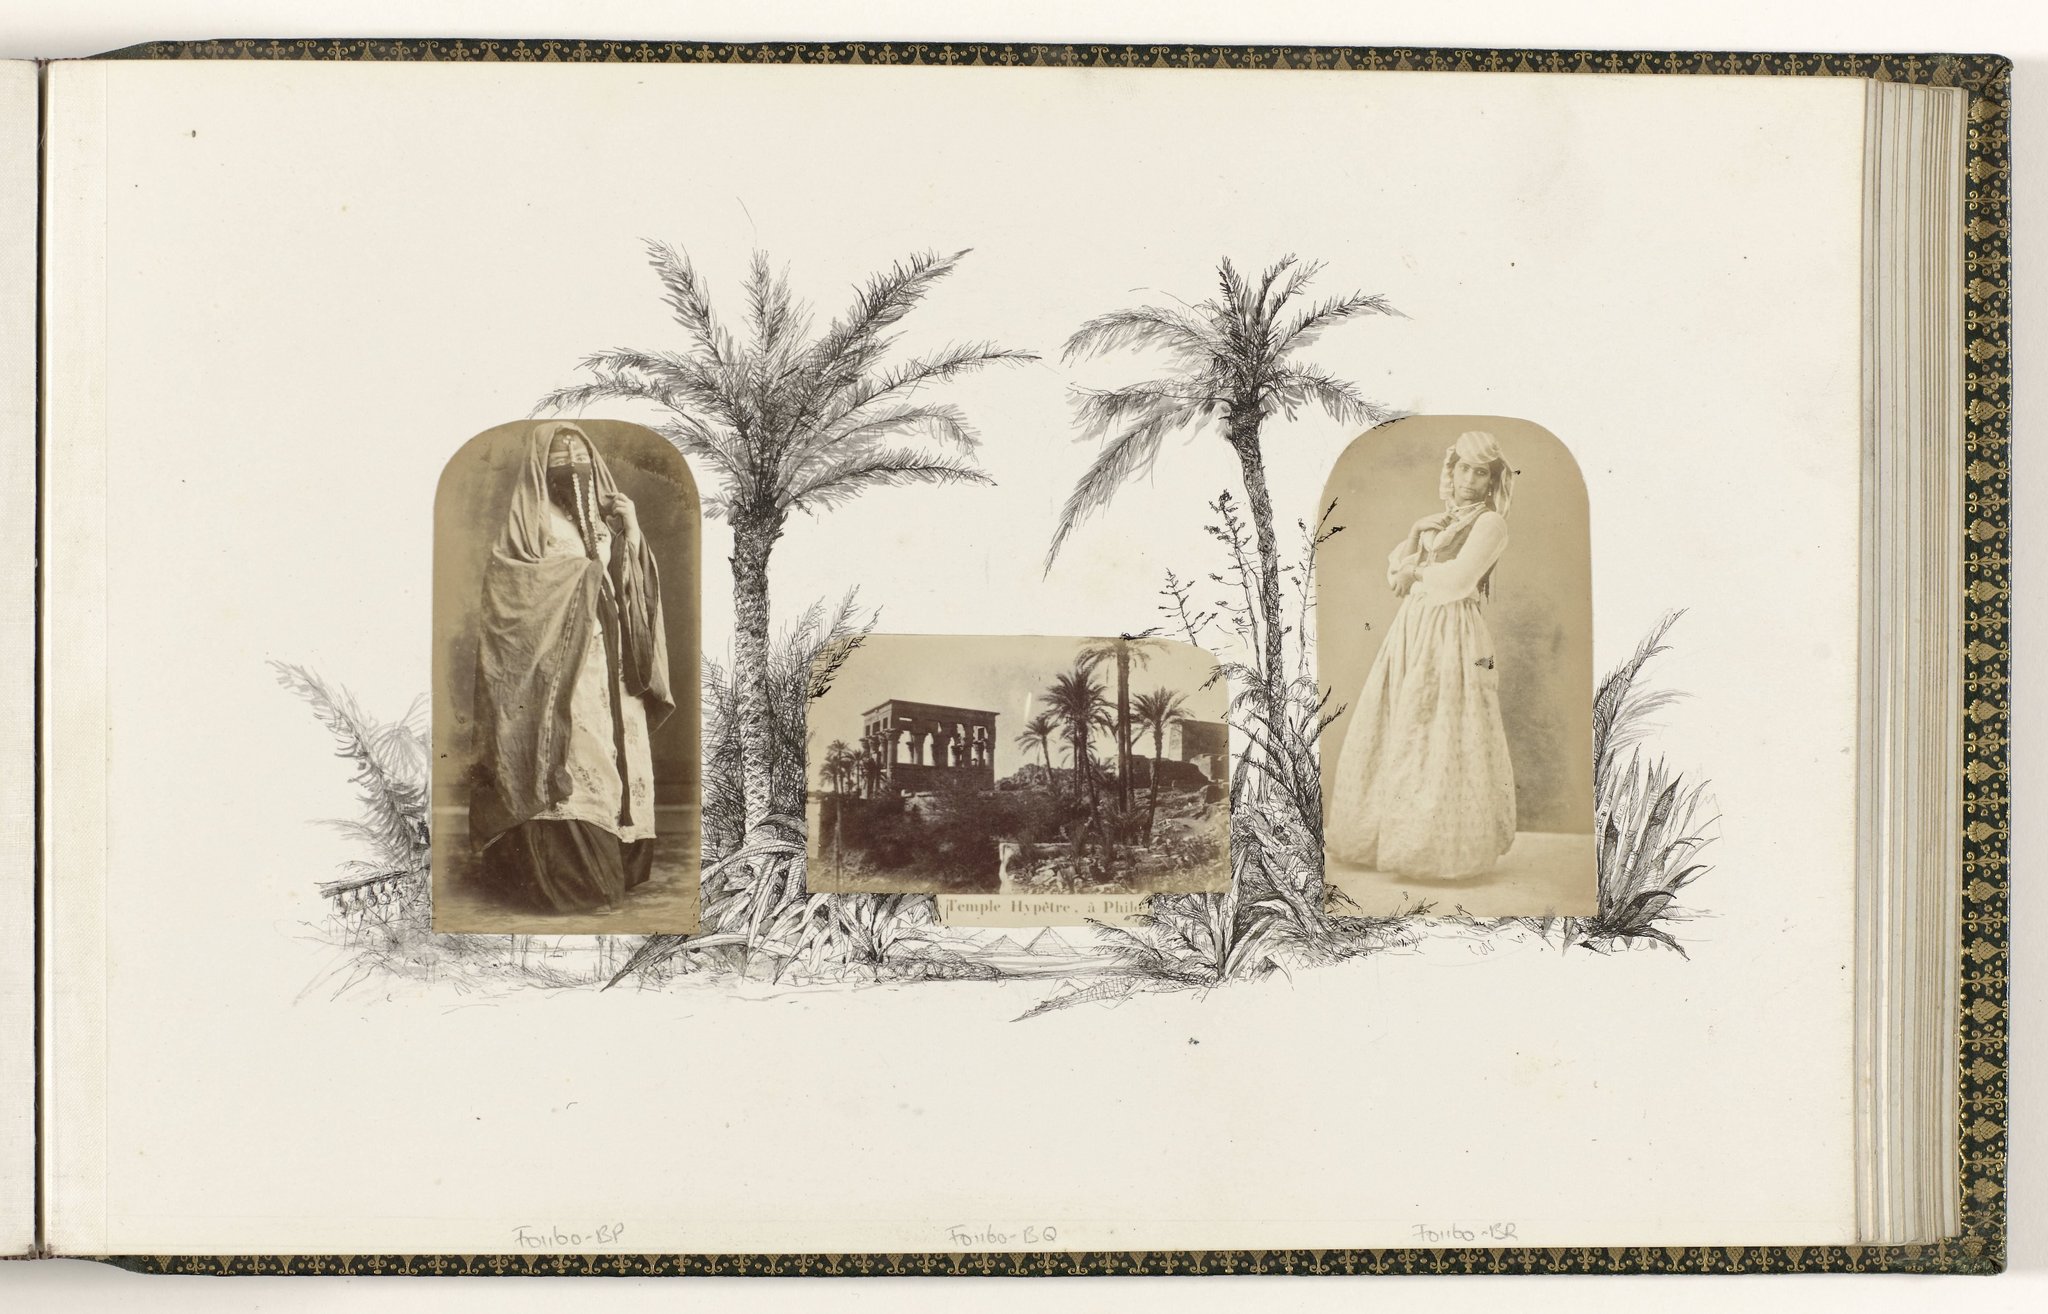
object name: photograph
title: Album with Photographs and Decorations Drawn in Indian Ink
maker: Anonymous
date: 1870-1880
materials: paper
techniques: albumen print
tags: historical persons - bb - woman, folk costume, regional costume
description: People in the 19th century could explore the world in the comfort of their own home with photographs like these. Gracing this album are sheets with photographs taken in England, France and Germany. The album also extends to far-flung places, including the heart of Africa with portraits of Stanley and Livingstone. Egypt is under review in this page. Two cut-out photographs of veiled women are pasted next to a shot of the Temple of Philae. The scene is surrounded by a landscape of drawn palm trees.